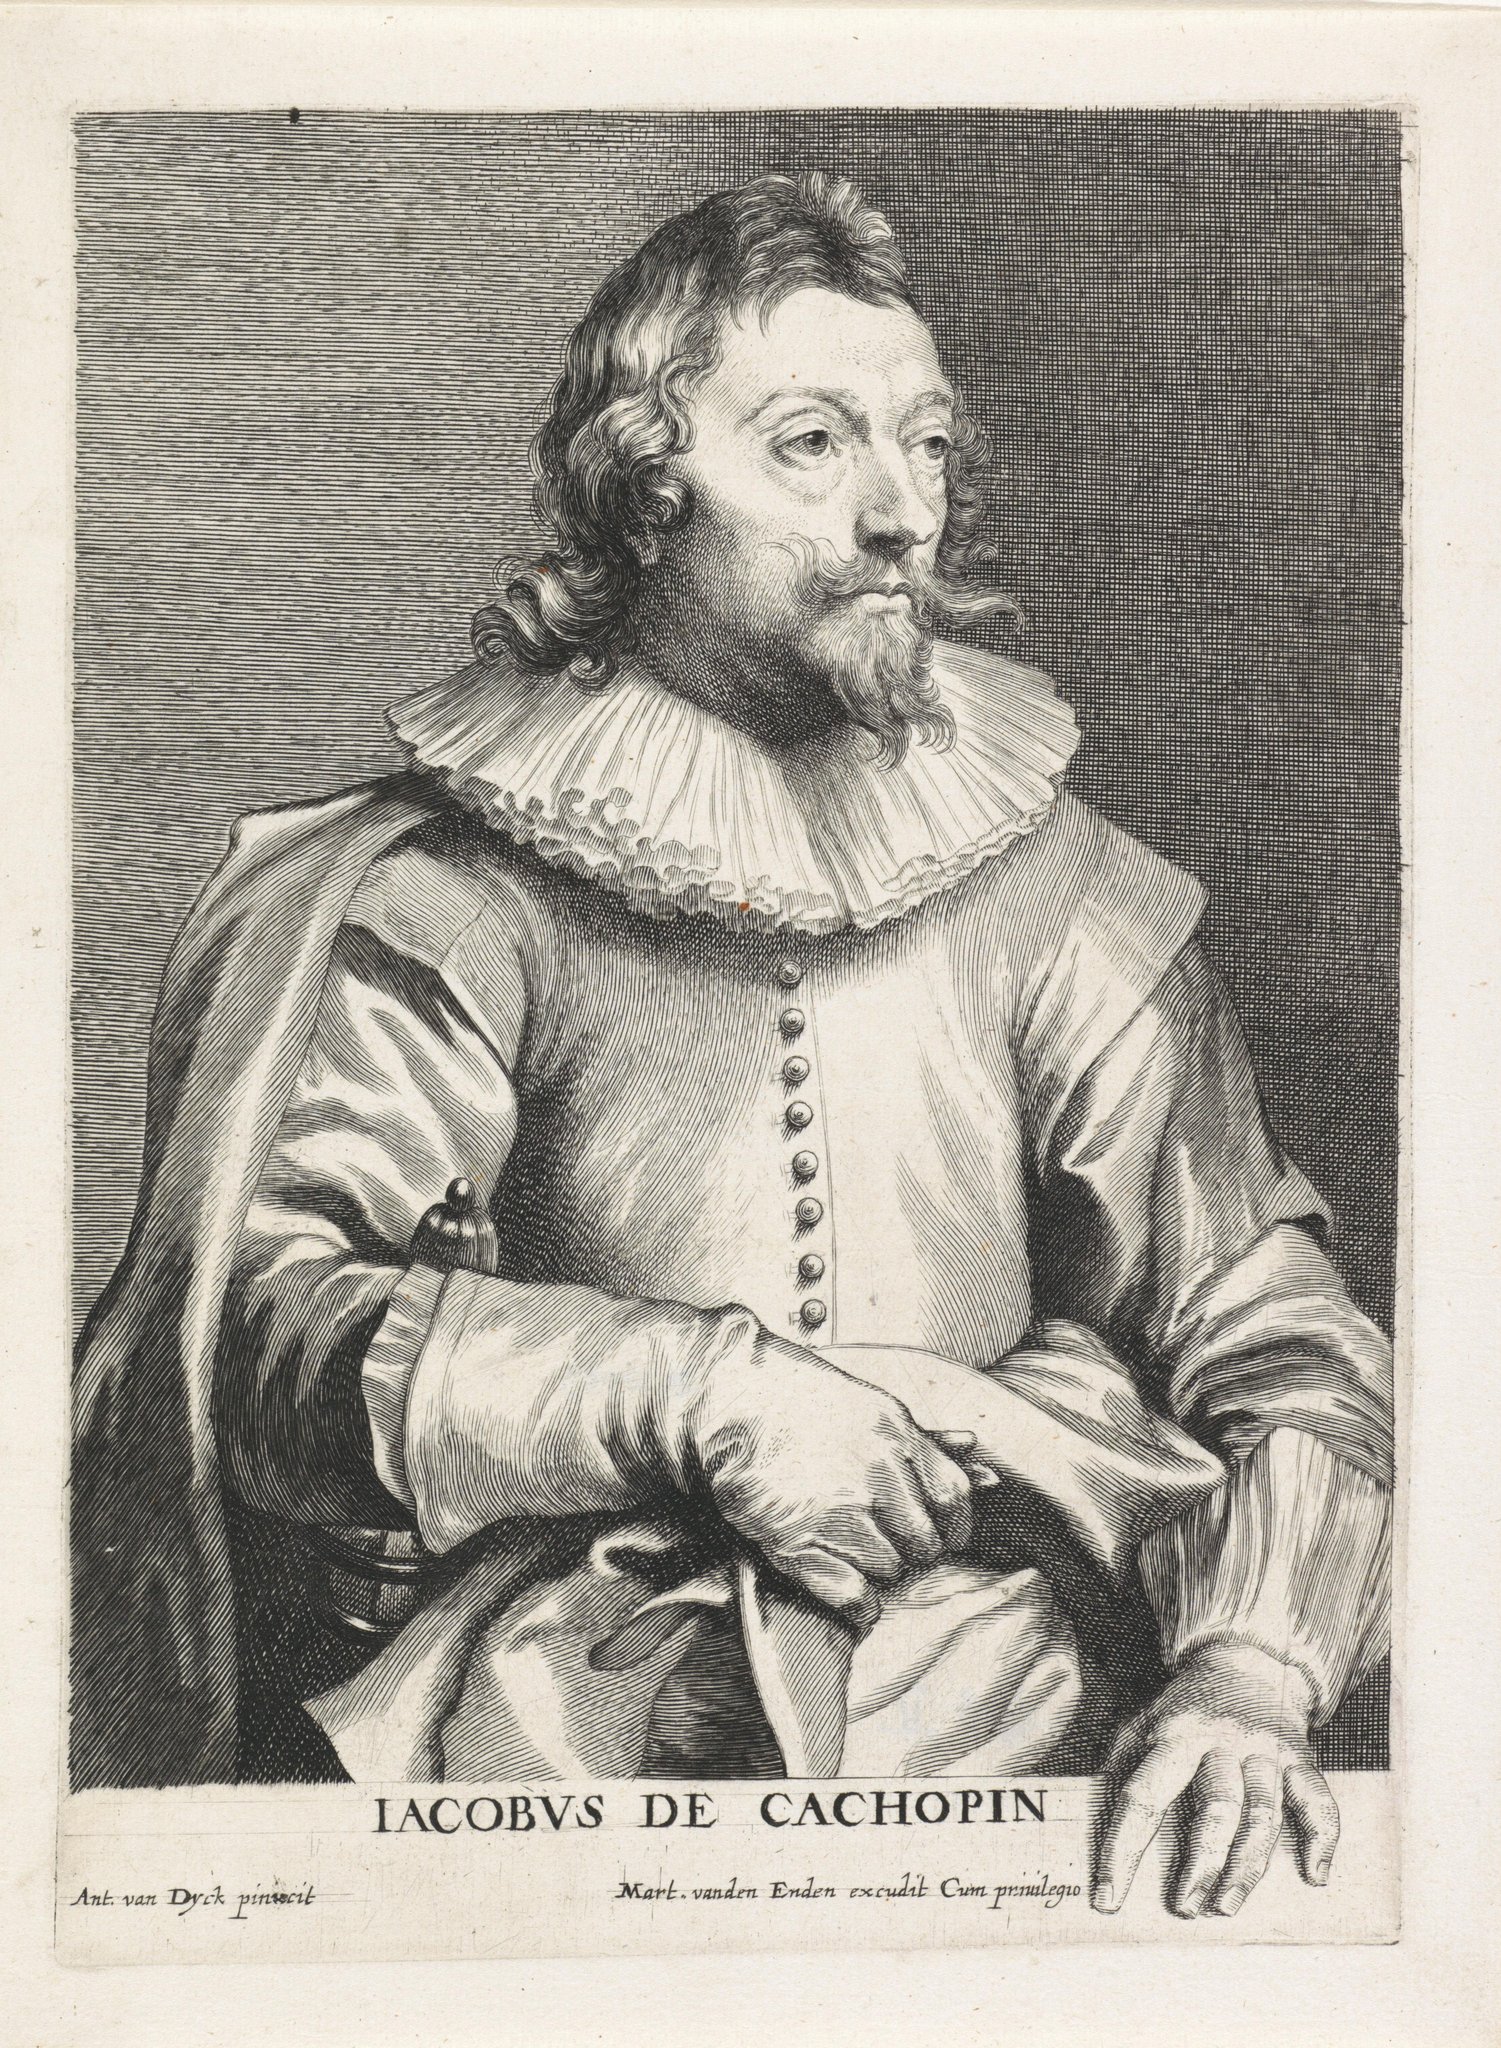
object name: print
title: Iconographie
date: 1630-1646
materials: paper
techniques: engraving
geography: antwerp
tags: gloves, mittens, etc.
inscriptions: collector's mark: Lugt 240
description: Prent gebruikt voor: Icones principum, virorum doctorum, pictorum, chalcographorum, statuariorum nec non amatorum pictoriae artis numero centum ab Ant. van Dyck ad vivum expressae ejusque sumptibus aeri incisae. Antwerpen: Gillis Hendricx, [1645-1646].